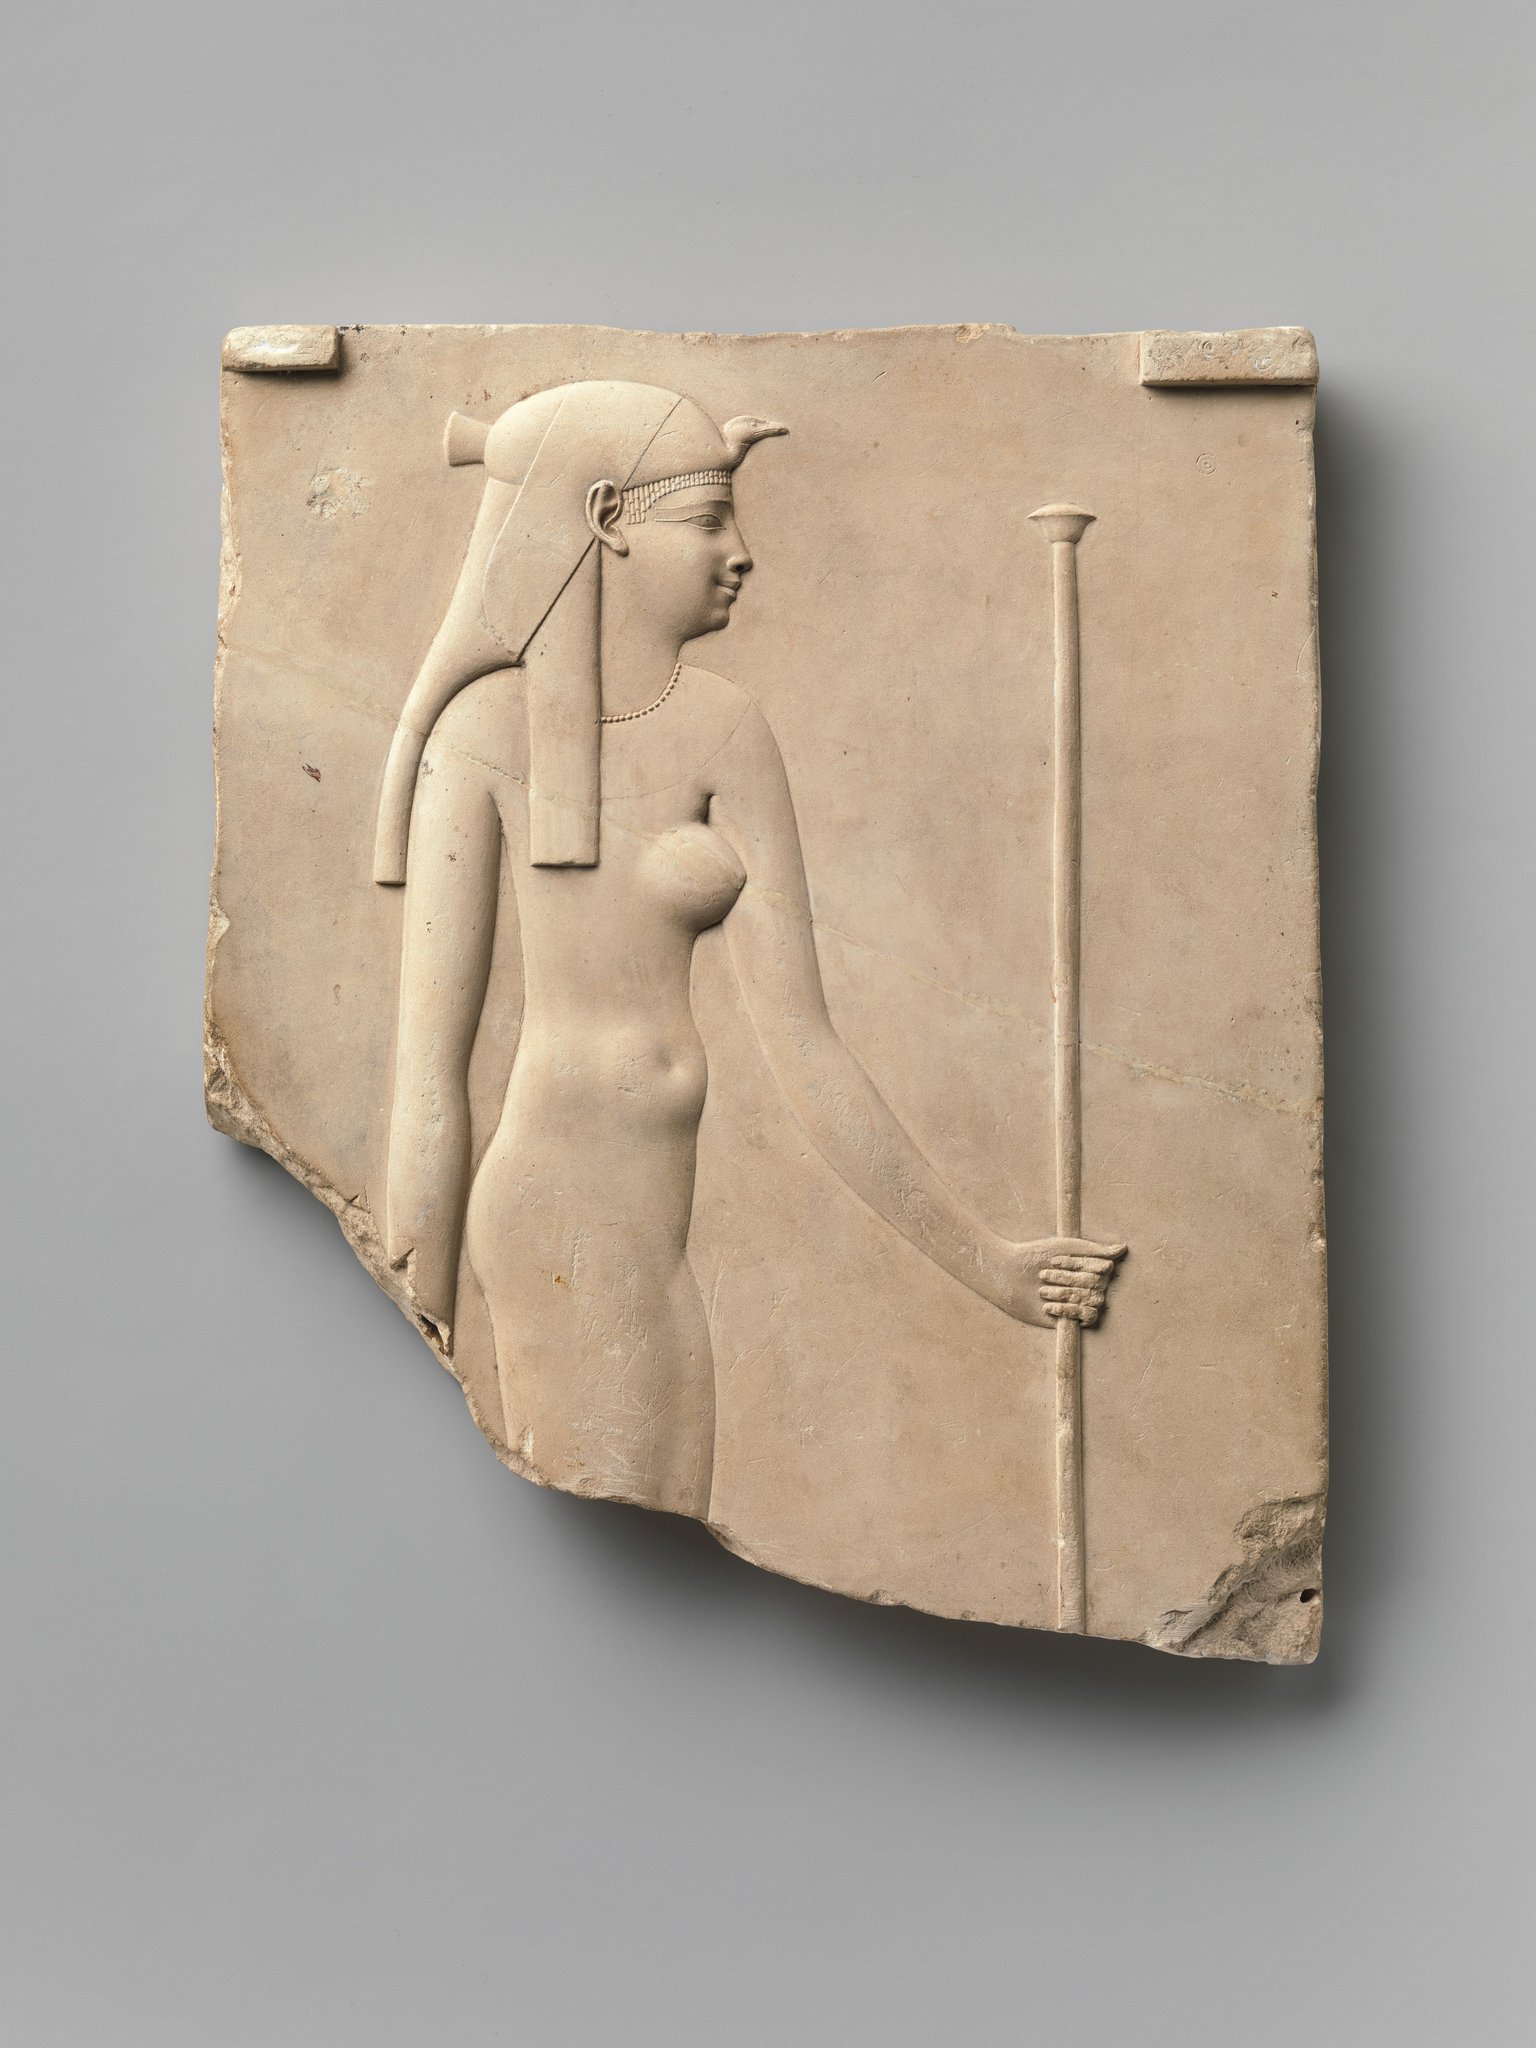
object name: sculptor's model, goddess, king on reverse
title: Plaque depicting a goddess, king on opposite side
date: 400-200 BCE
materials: limestone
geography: egypt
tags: kings,goddess